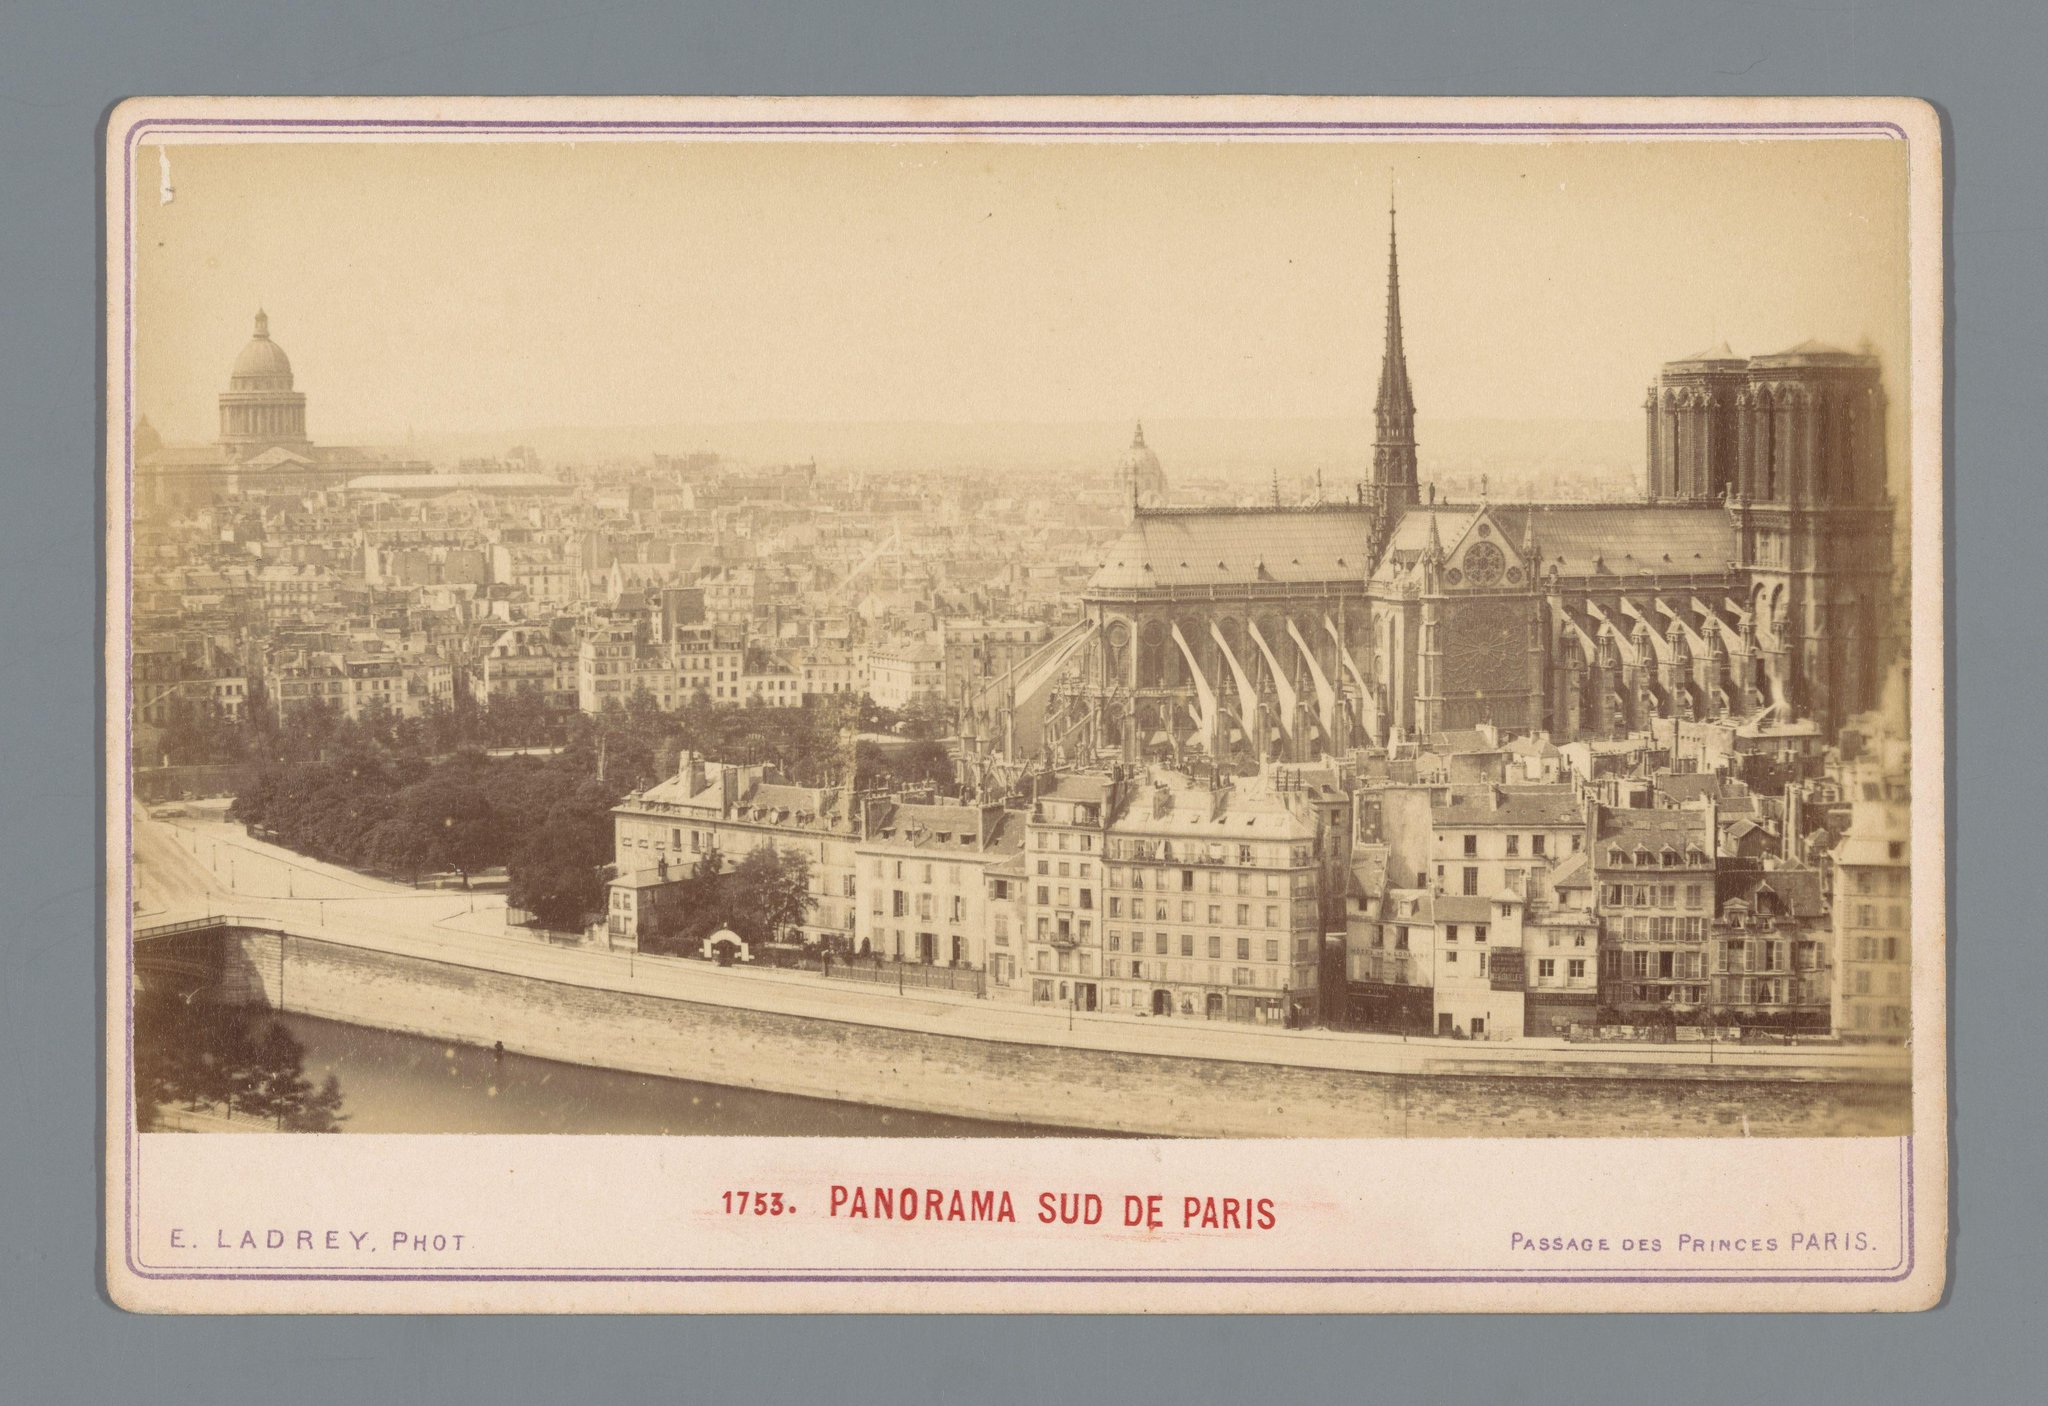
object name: cabinet photograph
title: Gezicht op de Notre-Dame te Parijs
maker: ernest ladrey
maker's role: fotograaf, illustrator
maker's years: 1830-1889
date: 1860-1890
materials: cardboard, photographic support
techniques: albumen print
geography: paris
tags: city-view in general; 'veduta', church (exterior), paris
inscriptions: number: ‘1753.’, retailer's mark: ‘Maison Martinet/ 12, boulevard des capucines 12,/ Grand-Hotel, Paris.’, : ‘Passage des Princes PARIS.’